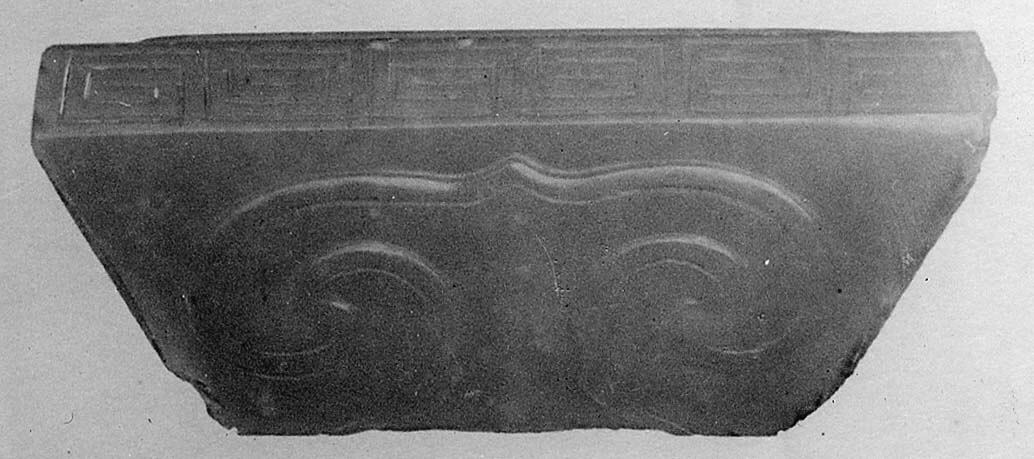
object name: fragment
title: Fragment of a Worked Object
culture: chinese or turkestani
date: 1902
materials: jade